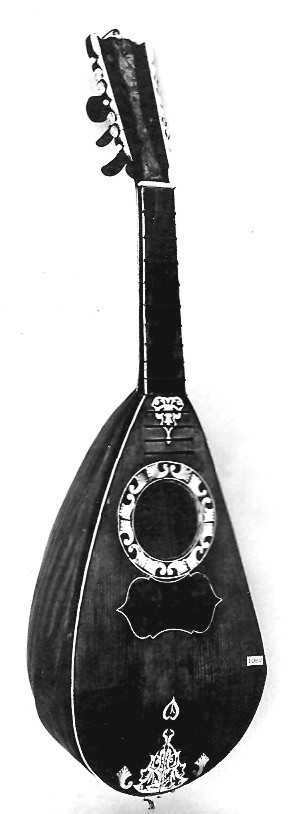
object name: mandola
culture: italian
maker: antonius vinaccia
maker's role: maker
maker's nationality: italian, naples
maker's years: 1754-1781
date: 1773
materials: brass, ivory, mother of pearl, wood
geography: italy